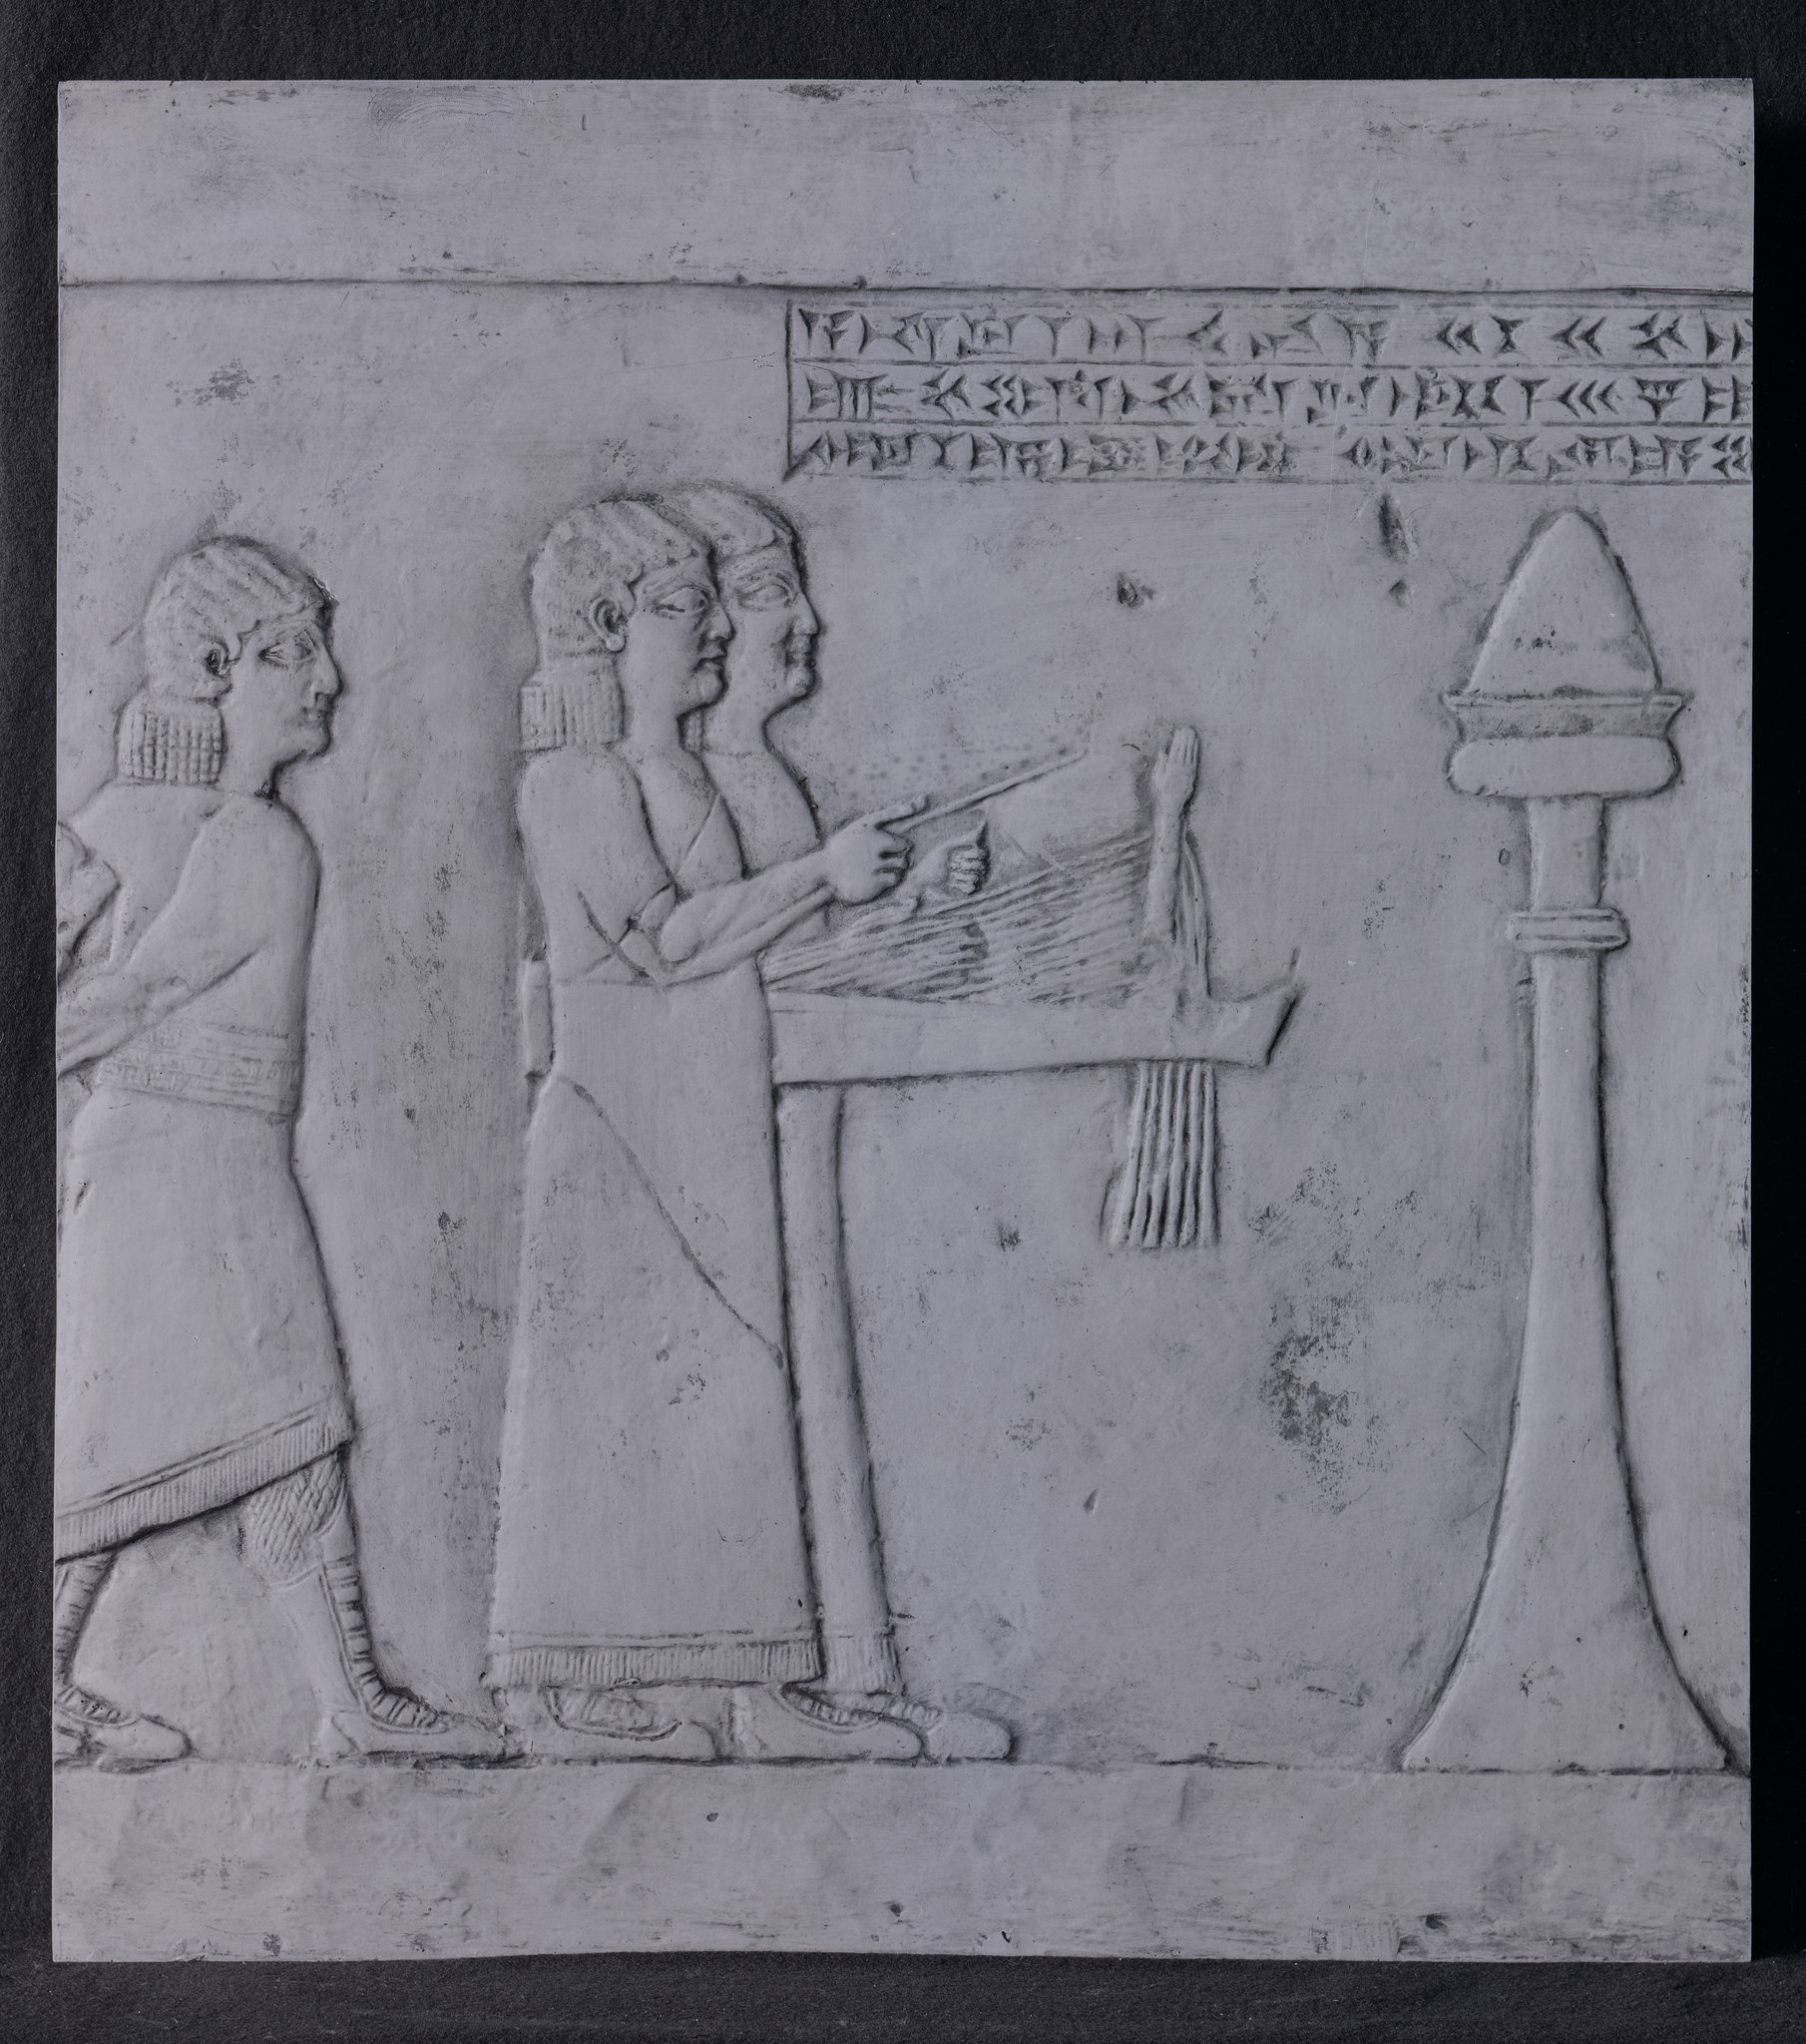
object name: cast of relief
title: Cast of relief: musicians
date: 7 BCE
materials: plaster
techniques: painting